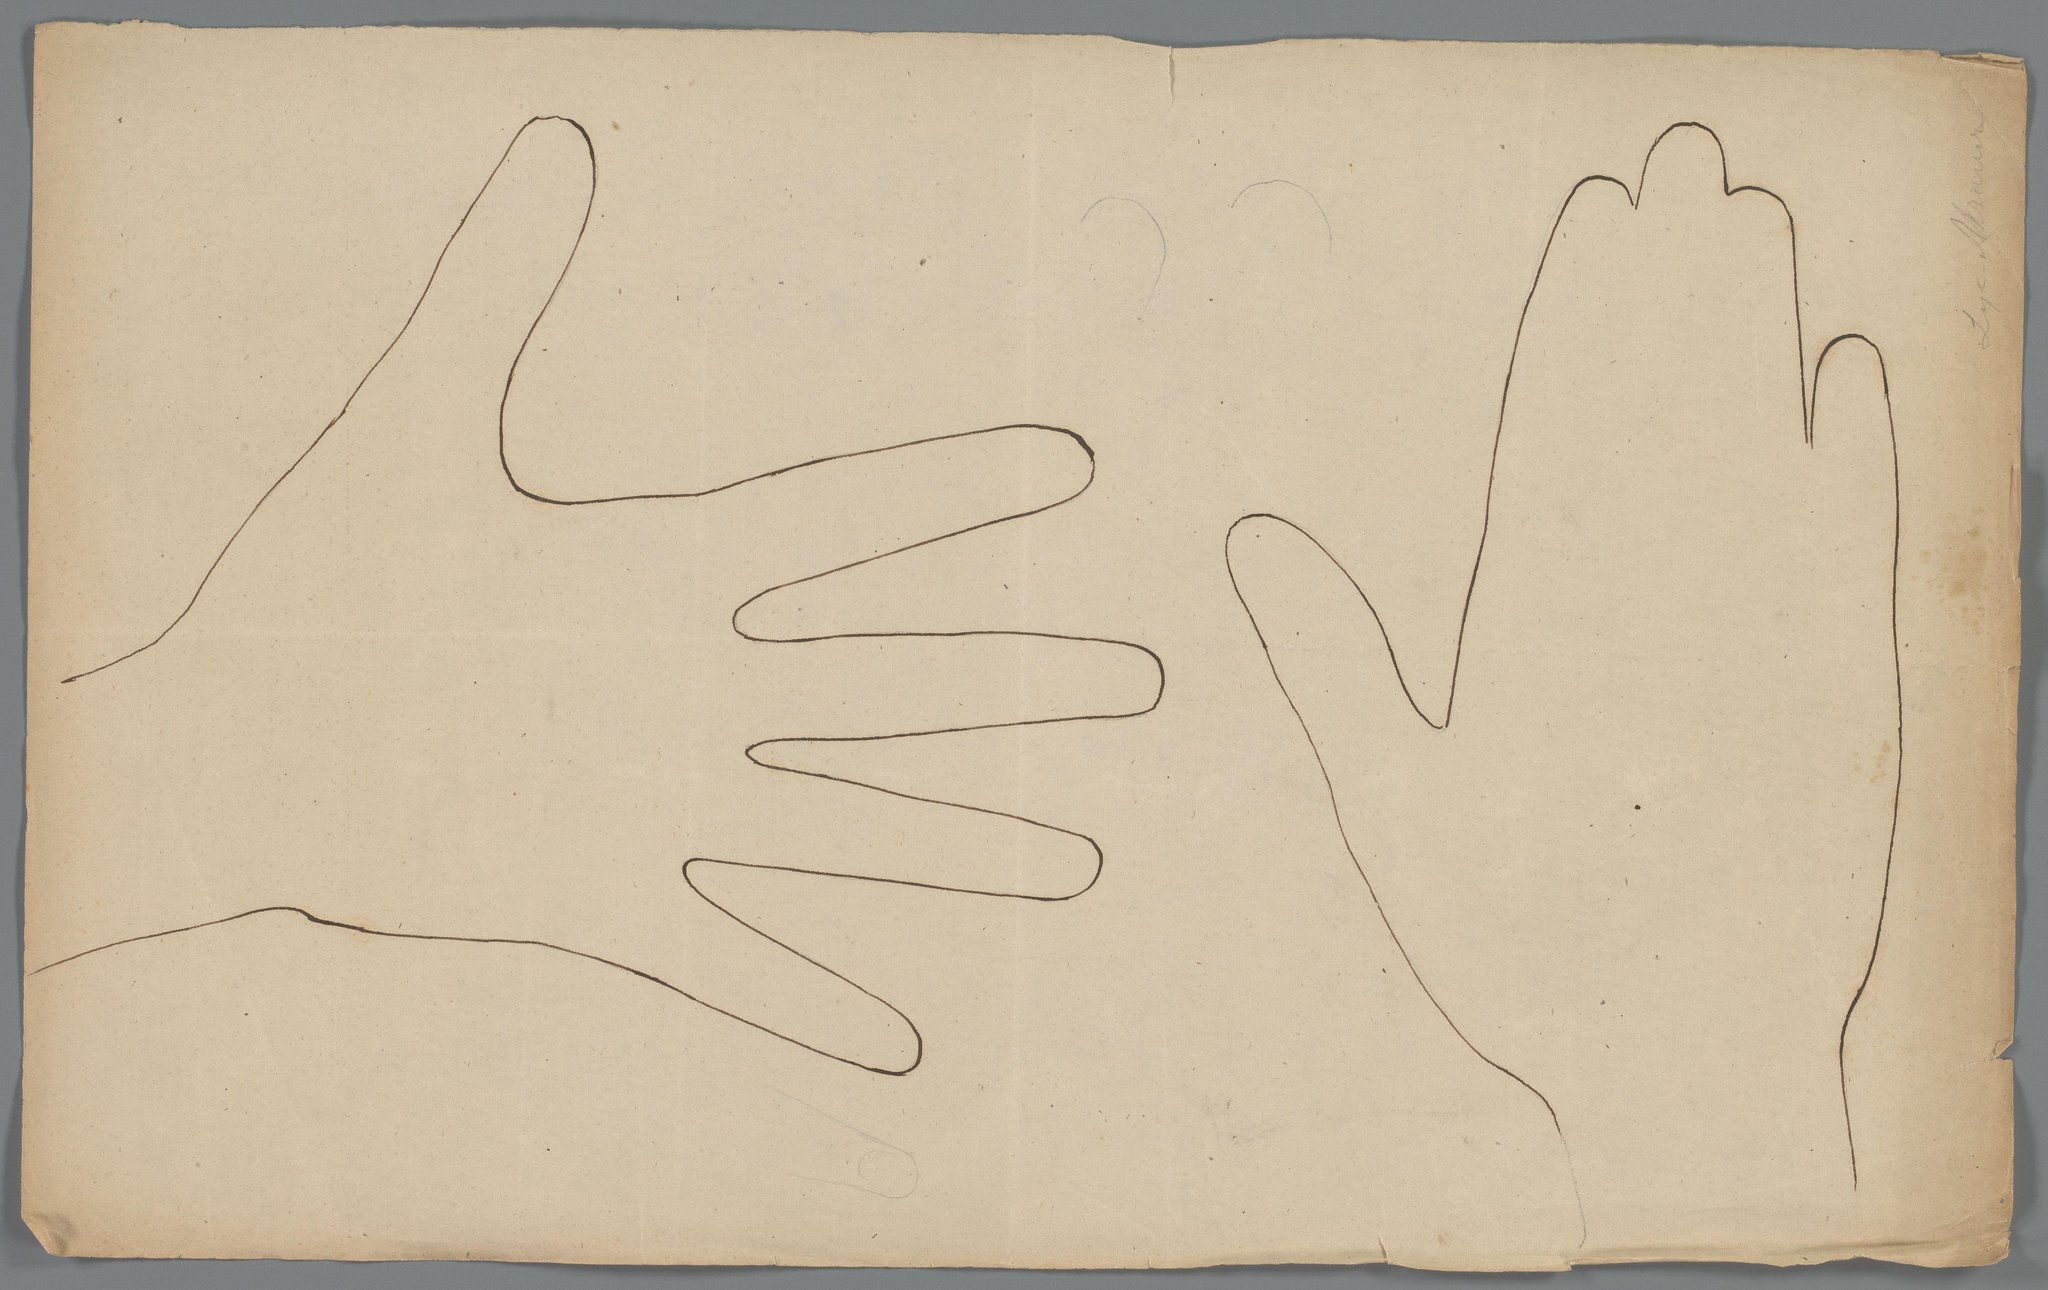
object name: drawing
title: Omtrek van een hand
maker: jacobus everhardus josephus van den berg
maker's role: draughtsman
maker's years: 1802-1861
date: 1812-1861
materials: ink, paper, pencil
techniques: pen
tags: postures and gestures of hand and fingers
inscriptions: inscription: ‘Lyc. [...]’